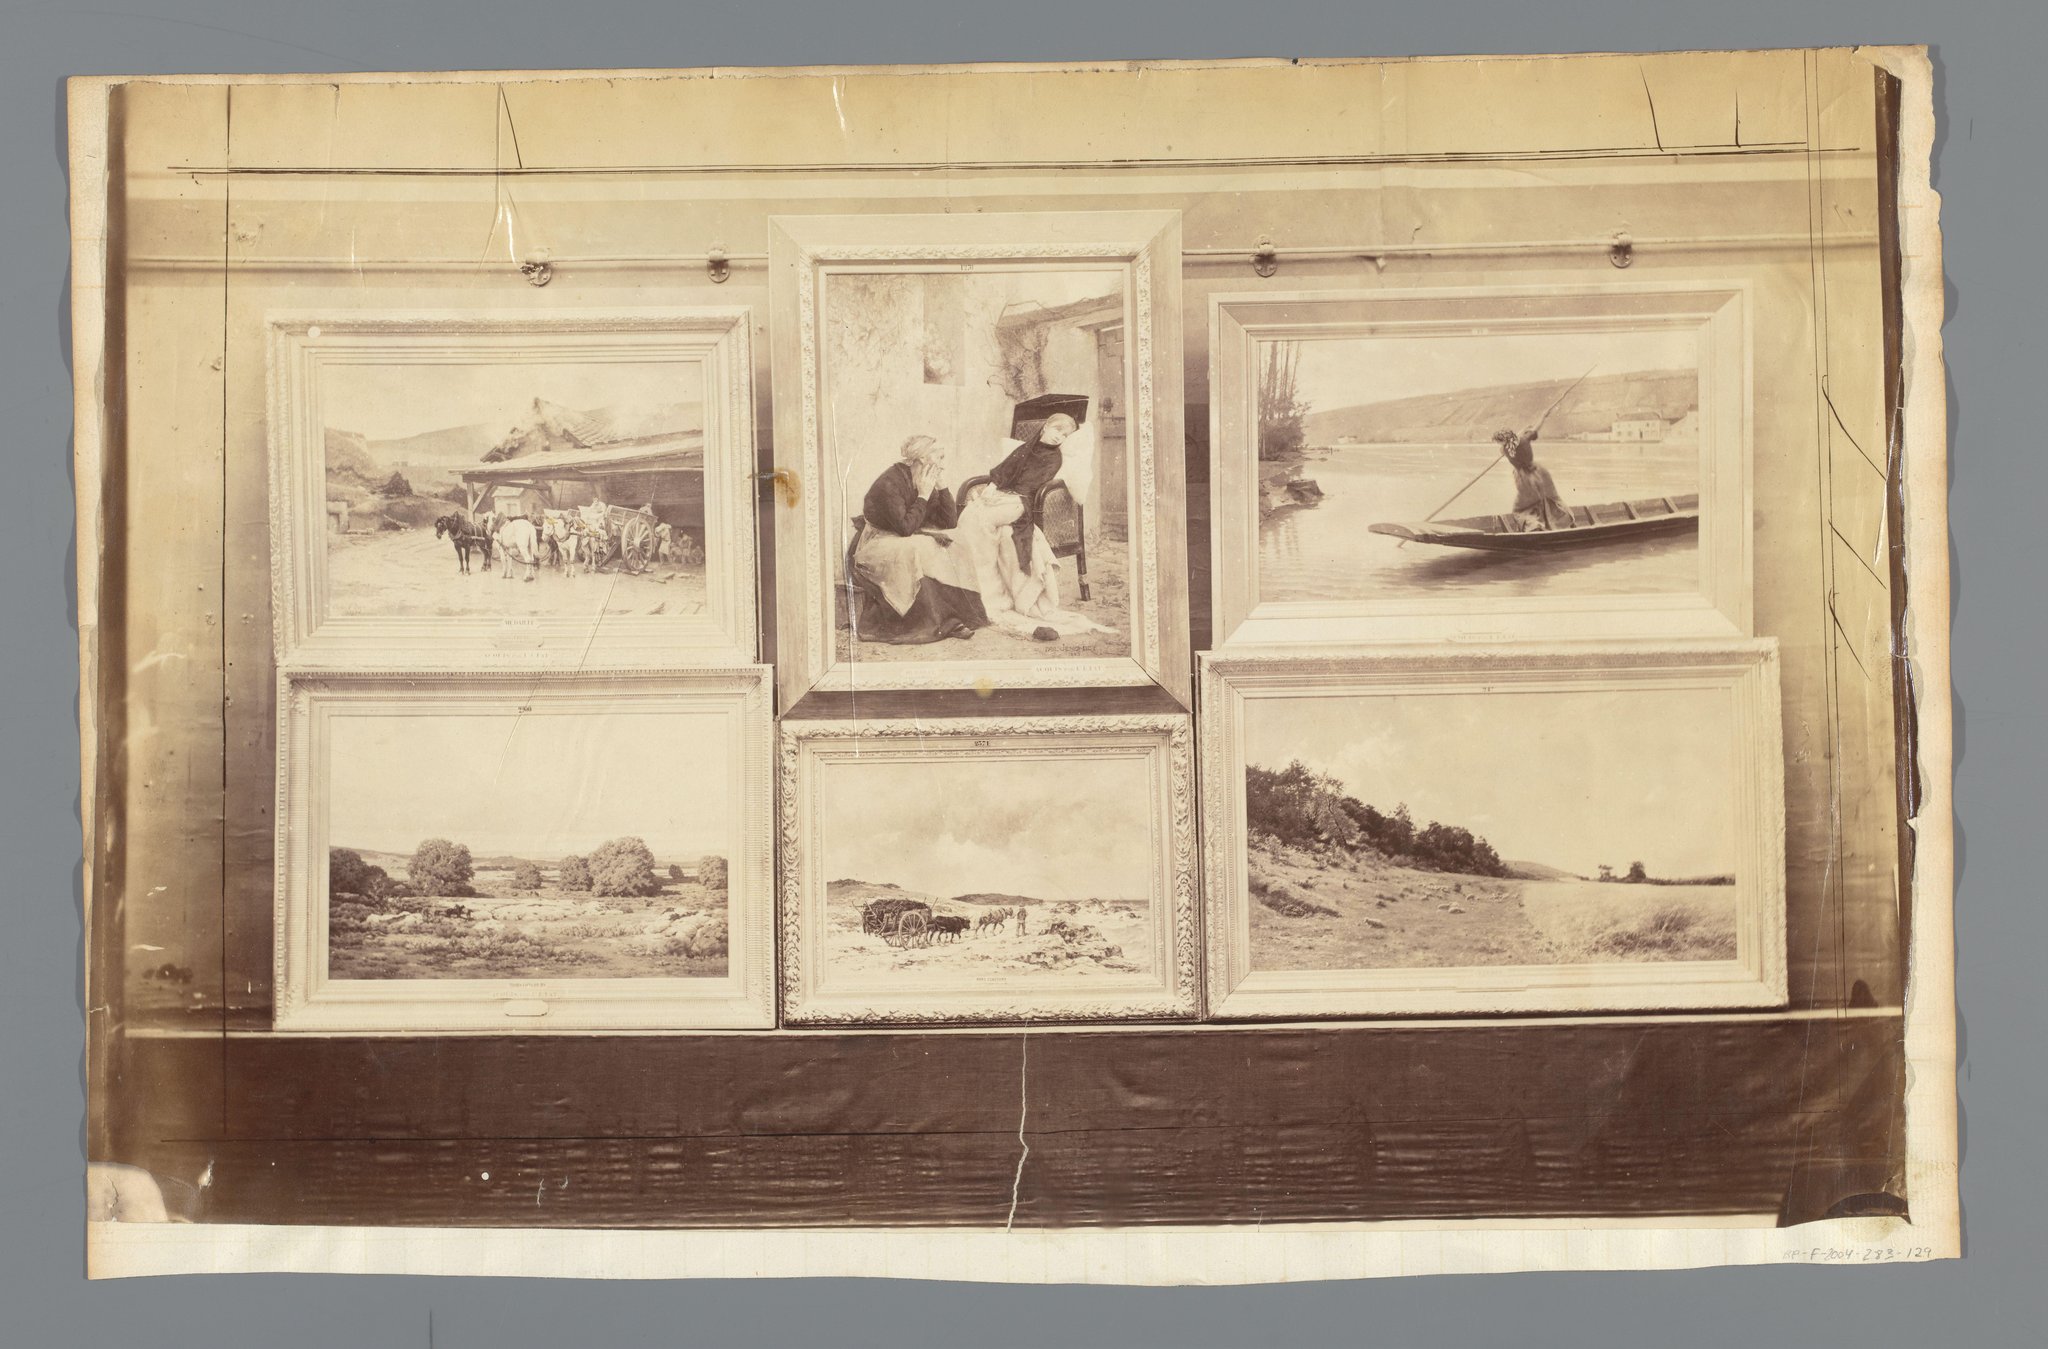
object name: photograph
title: Zes schilderijen aan een wand, waaronder landschappen en genrestukken, vermoedelijk tijdens een salon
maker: Anonymous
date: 1883-1900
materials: paper, photographic support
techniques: albumen print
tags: picture, painting, temporary exhibition, 'salon'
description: Schilderij linksboven gesigneerd [...] Frère; schilderij midden boven Paul Janoudet 1883. Onderdeel van Frans kunstenaarsalbum.